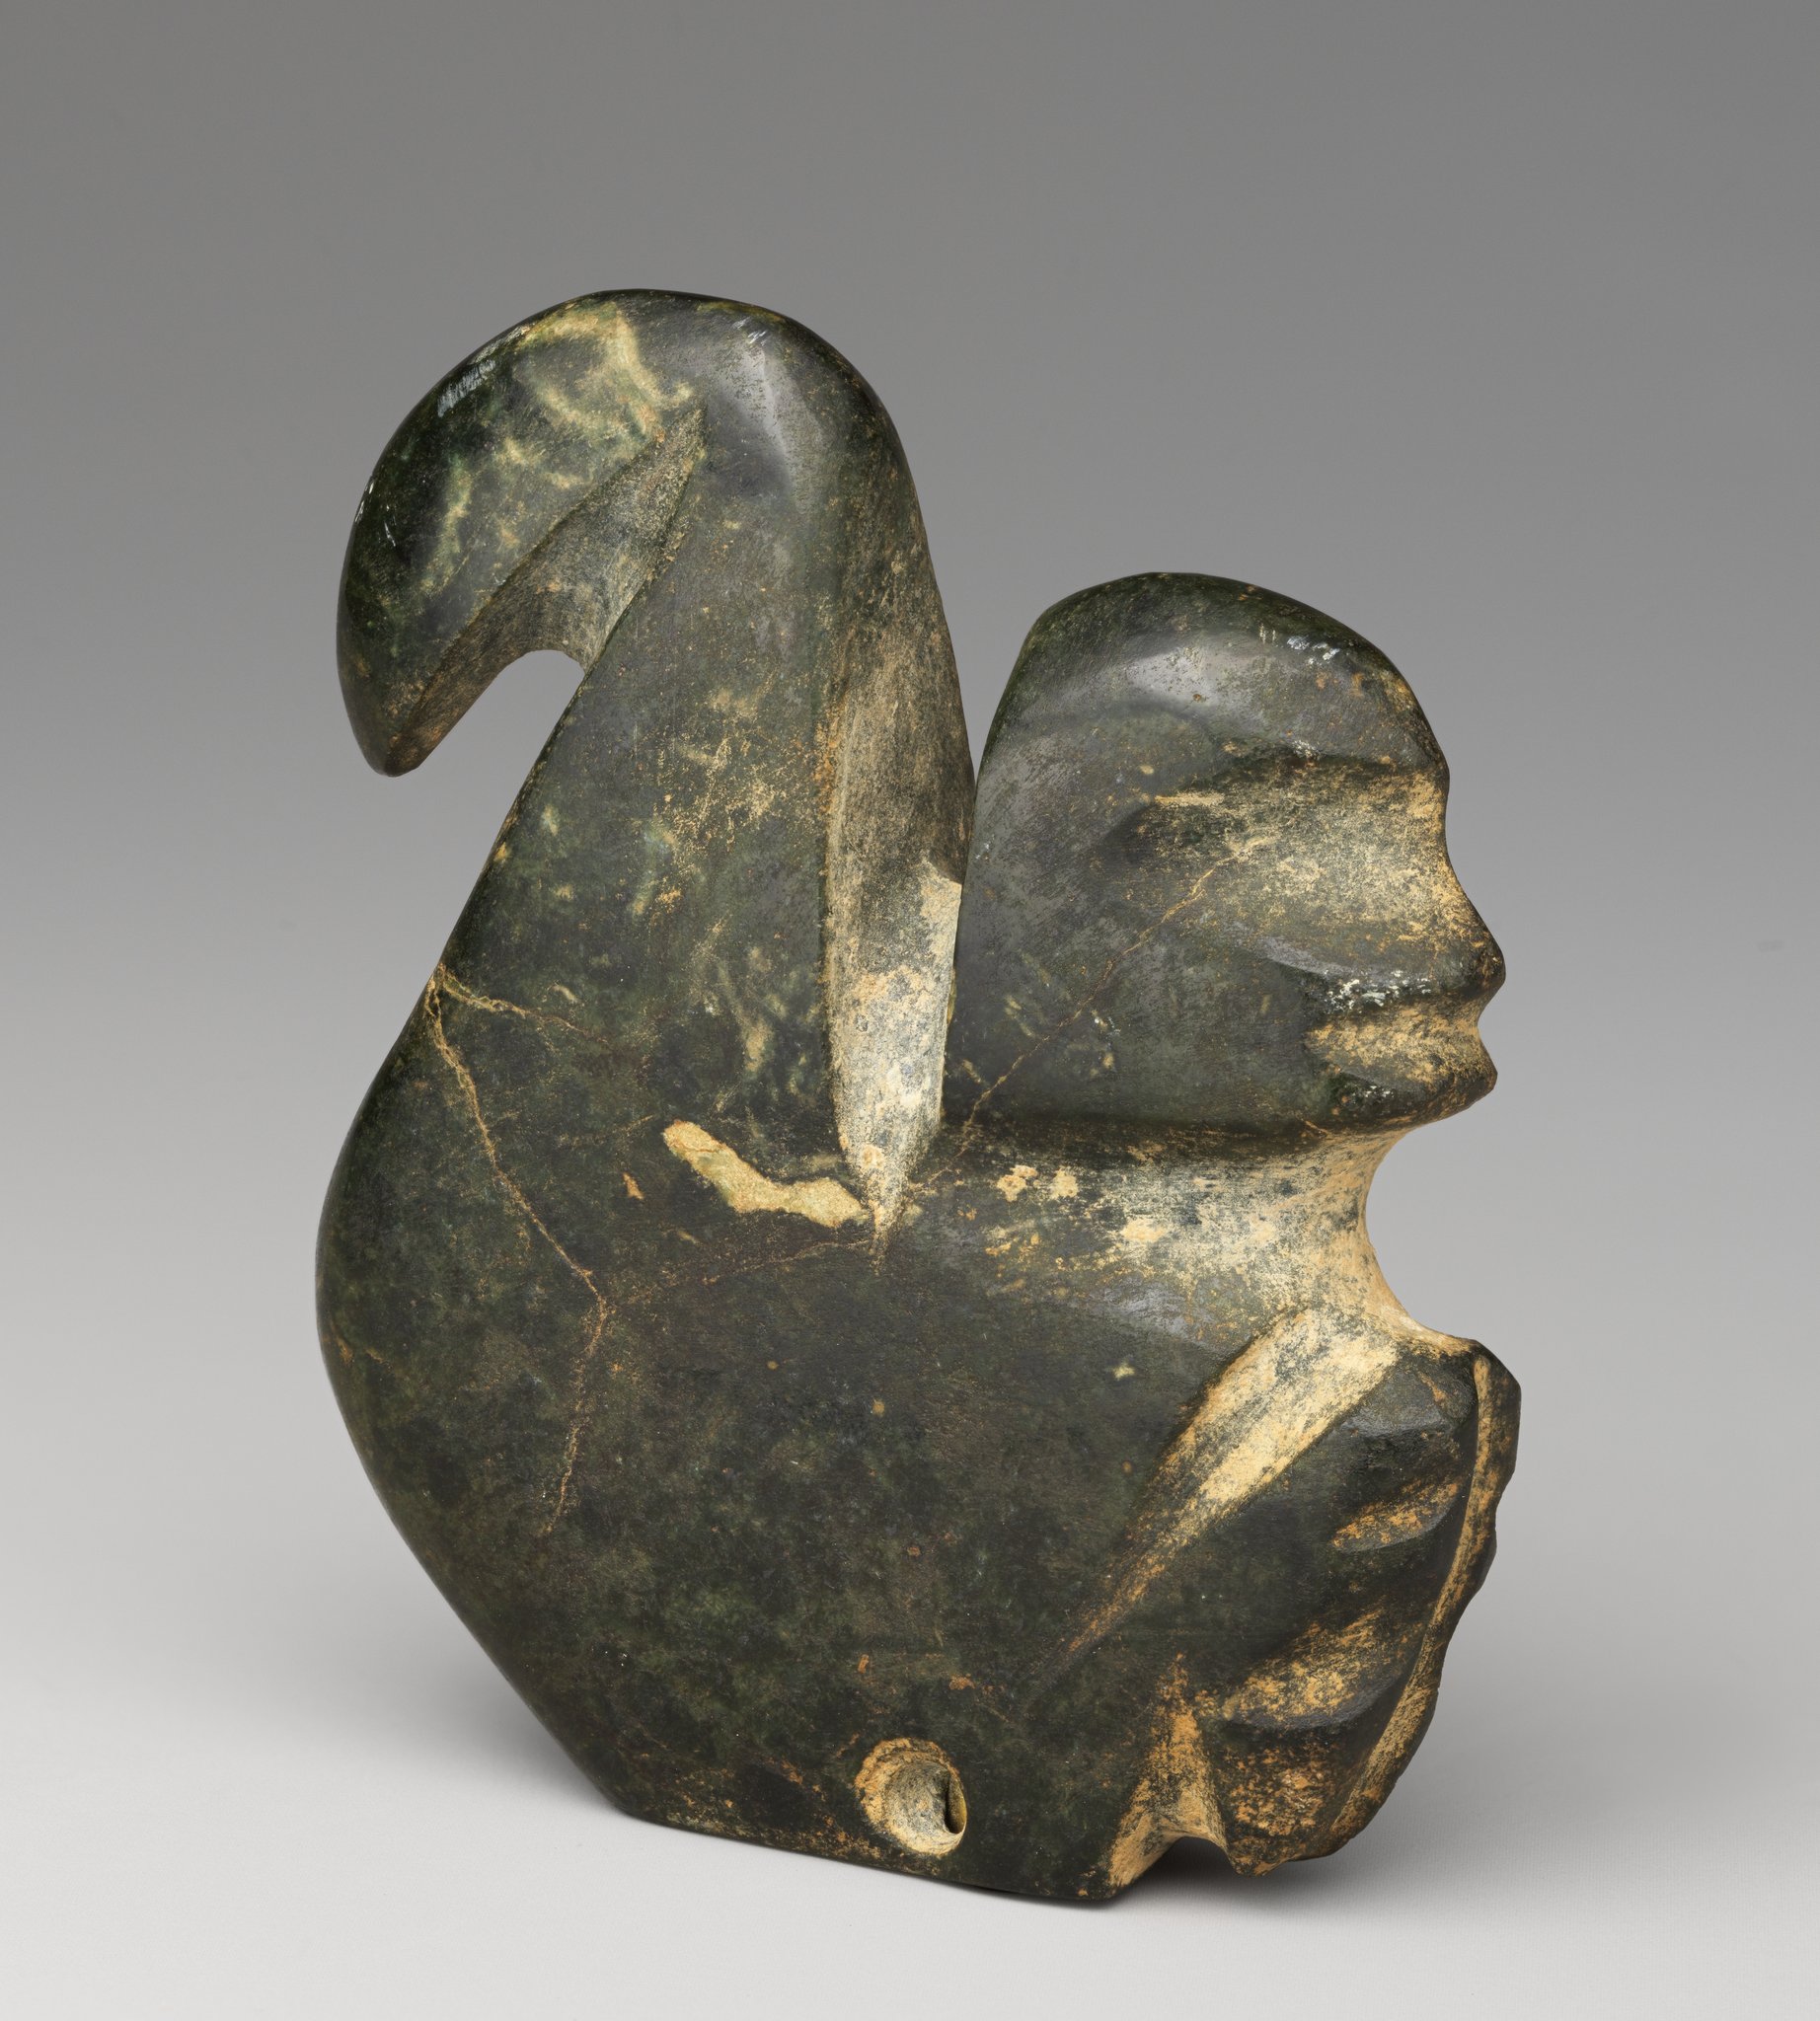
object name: figure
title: Stone Animal Figure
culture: mezcala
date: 1-800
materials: stone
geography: mexico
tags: animals